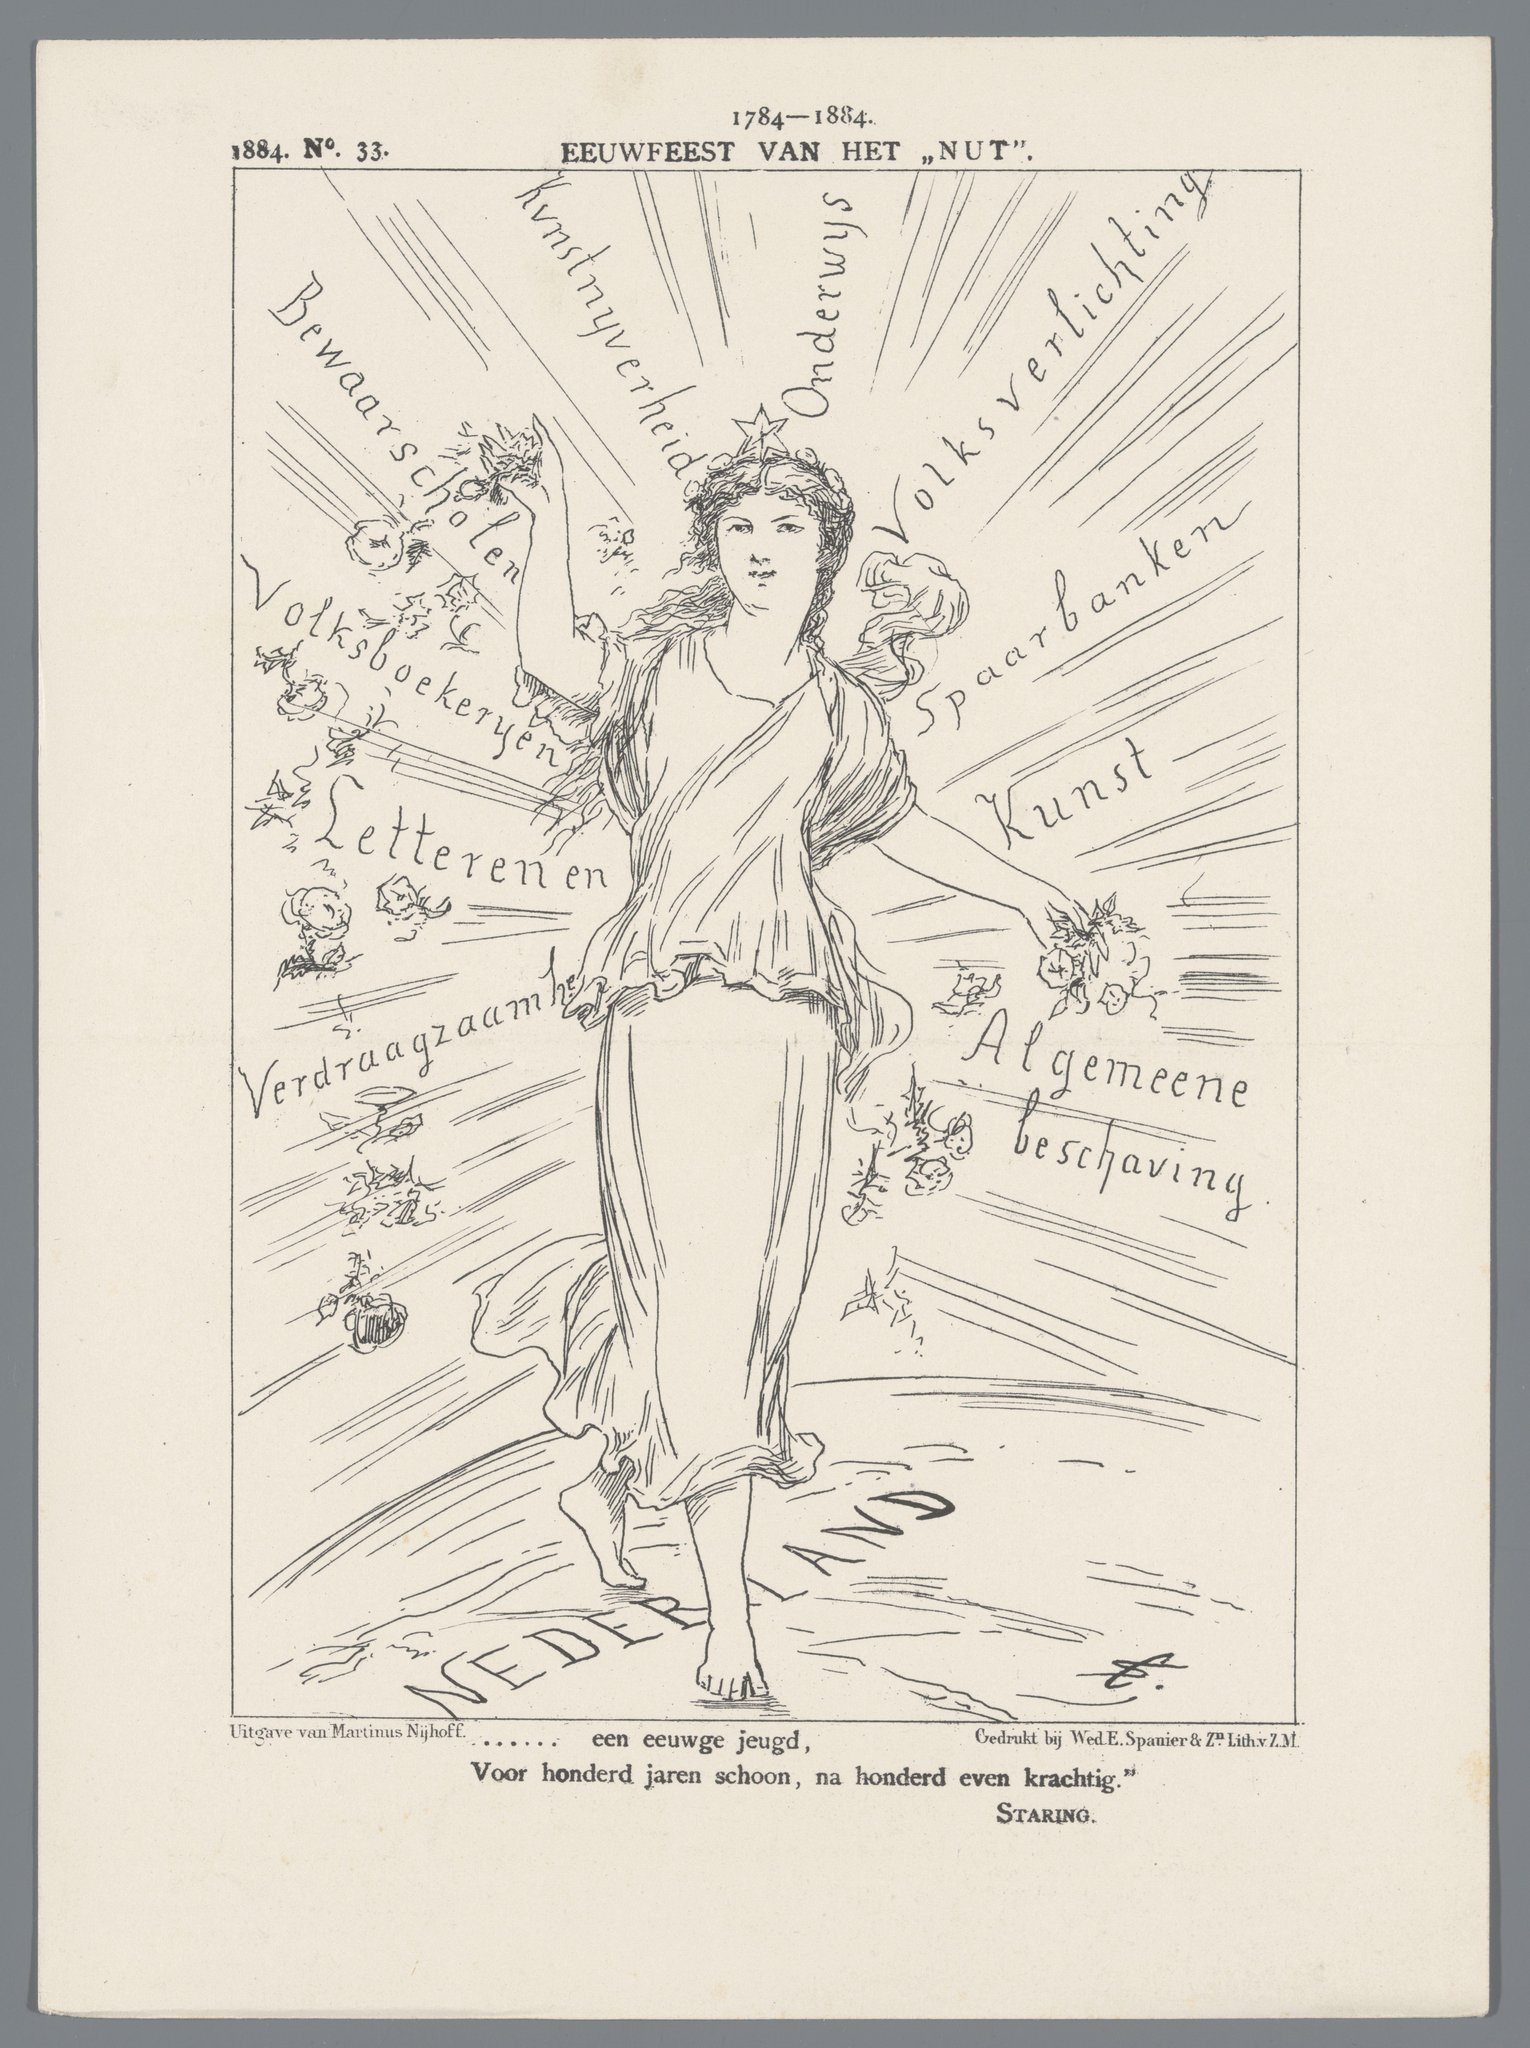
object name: print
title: Jubileum van de Maatschappij tot Nut van 't Algemeen, 1784-1884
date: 1884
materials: paper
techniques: lithograph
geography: netherlands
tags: maatschappij tot nut van 't algemeen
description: Honderjarig jubileum van de Maatschappij tot Nut van 't Algemeen, 1784-1884. Plaat verschenen bij het weekblad De Nederlandsche Spectator, nr. 33, 1884.